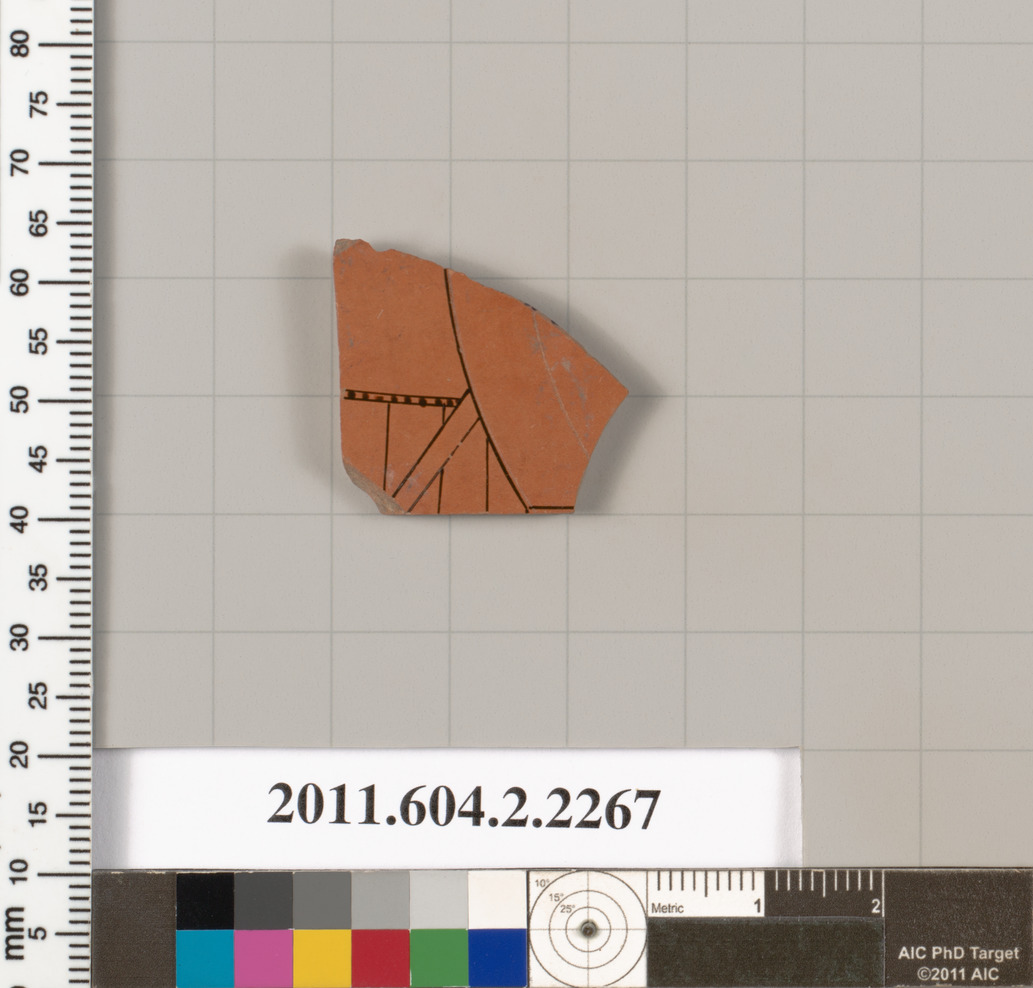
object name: pot fragment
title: Terracotta fragment of a pot; glazed on the inside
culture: greek, attic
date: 475-451 BCE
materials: terracotta